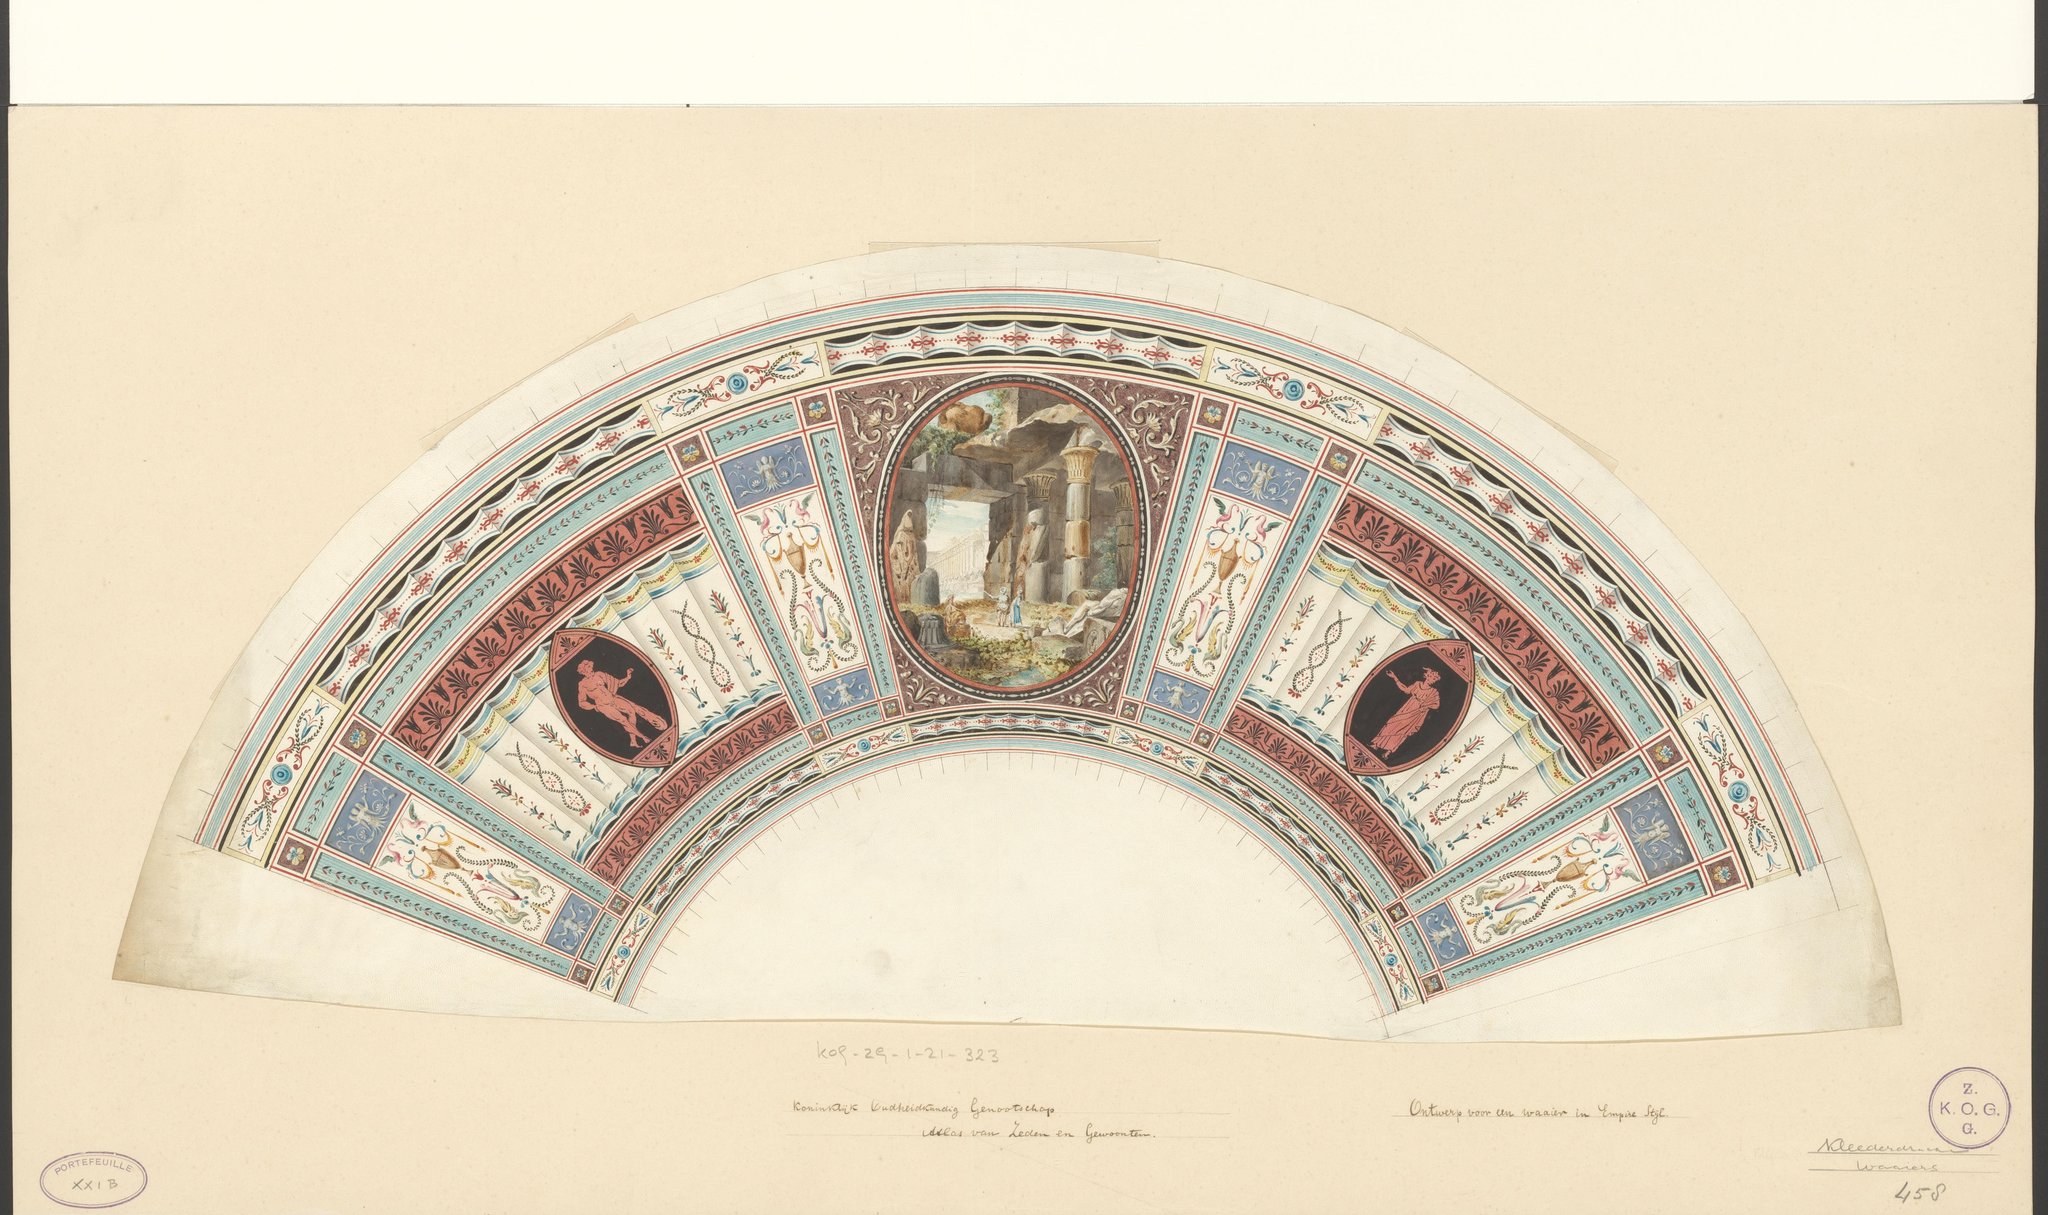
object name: fan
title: Waaier in empirestijl met ruïne van een tempel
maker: Anonymous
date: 1800-1825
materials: parchment, watercolor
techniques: brush, pen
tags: (story of) hercules (heracles), ornament ~ grotesque, fan, ruin of a dwelling, house, castle, etc.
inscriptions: collector's mark: Lugt 1641, stamp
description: Onderwerpsrubrieken binnen de Atlas Zeden en Gewoonten: Zeden en Gewoonten in Engeren Zin, De Kleeding, Lijfsieraden, waaiers, schoeisel.